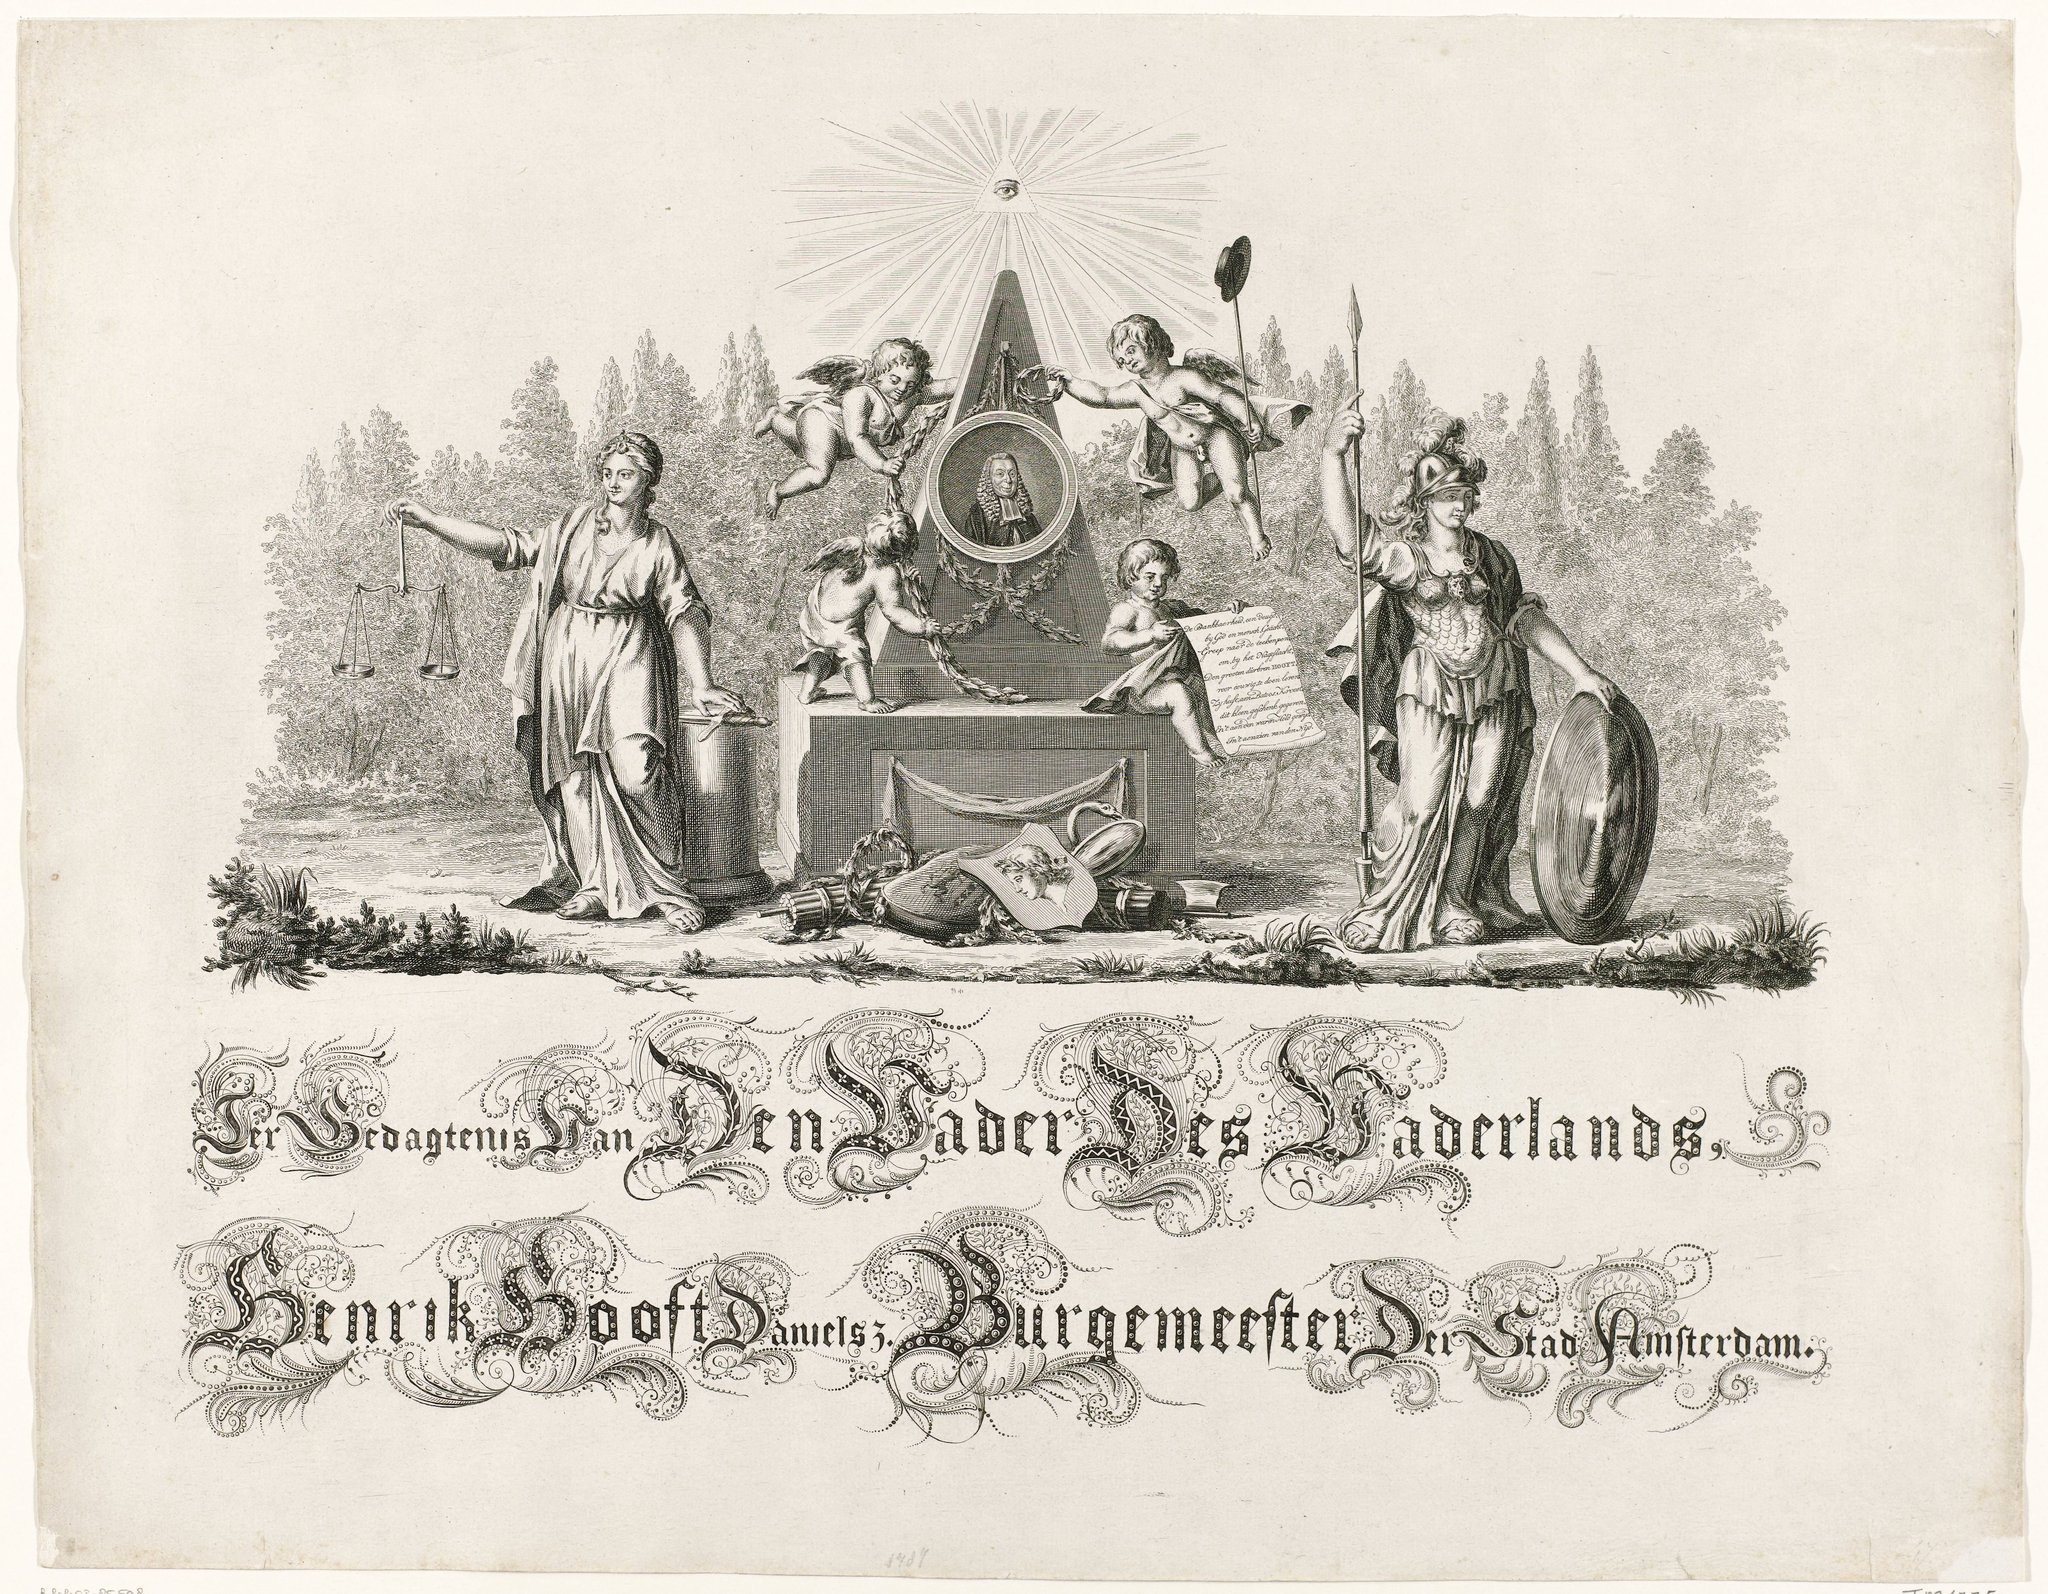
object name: print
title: Ter Gedagtenis van Den Vader des Vaderlands, Henrik Hooft Danielsz. Burgemeester Der Stad Amsterdam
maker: Anonymous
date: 1787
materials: paper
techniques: engraving, etching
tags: hendrik danielsz. hooft, justice, 'justitia'; 'giustitia divina' (ripa) ~ one of the four cardinal virtues, historical persons, calligraphy, the all-seeing eye, triangle with eye ~ symbol of god the father, freedom, liberty; 'libertà' (ripa) (+ abstract concept represented by female figure), patriots (1780-1795)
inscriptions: collector's mark: Lugt 2228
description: Allegorisch monument voor de Amsterdamse burgemeester Hendrik Danielsz. Hooft, naar aanleiding van zijn verdediging van de patriotse belangen in de raad op 26 februari 1787. Portretmedaillon met pruik op obelisk, drie putti omhangen het monument met eikenloof. Links de Rechtvaardigheid, rechts de Vrijheid. In de lucht het Alziende Oog. Met gekalligrafeerde titel.